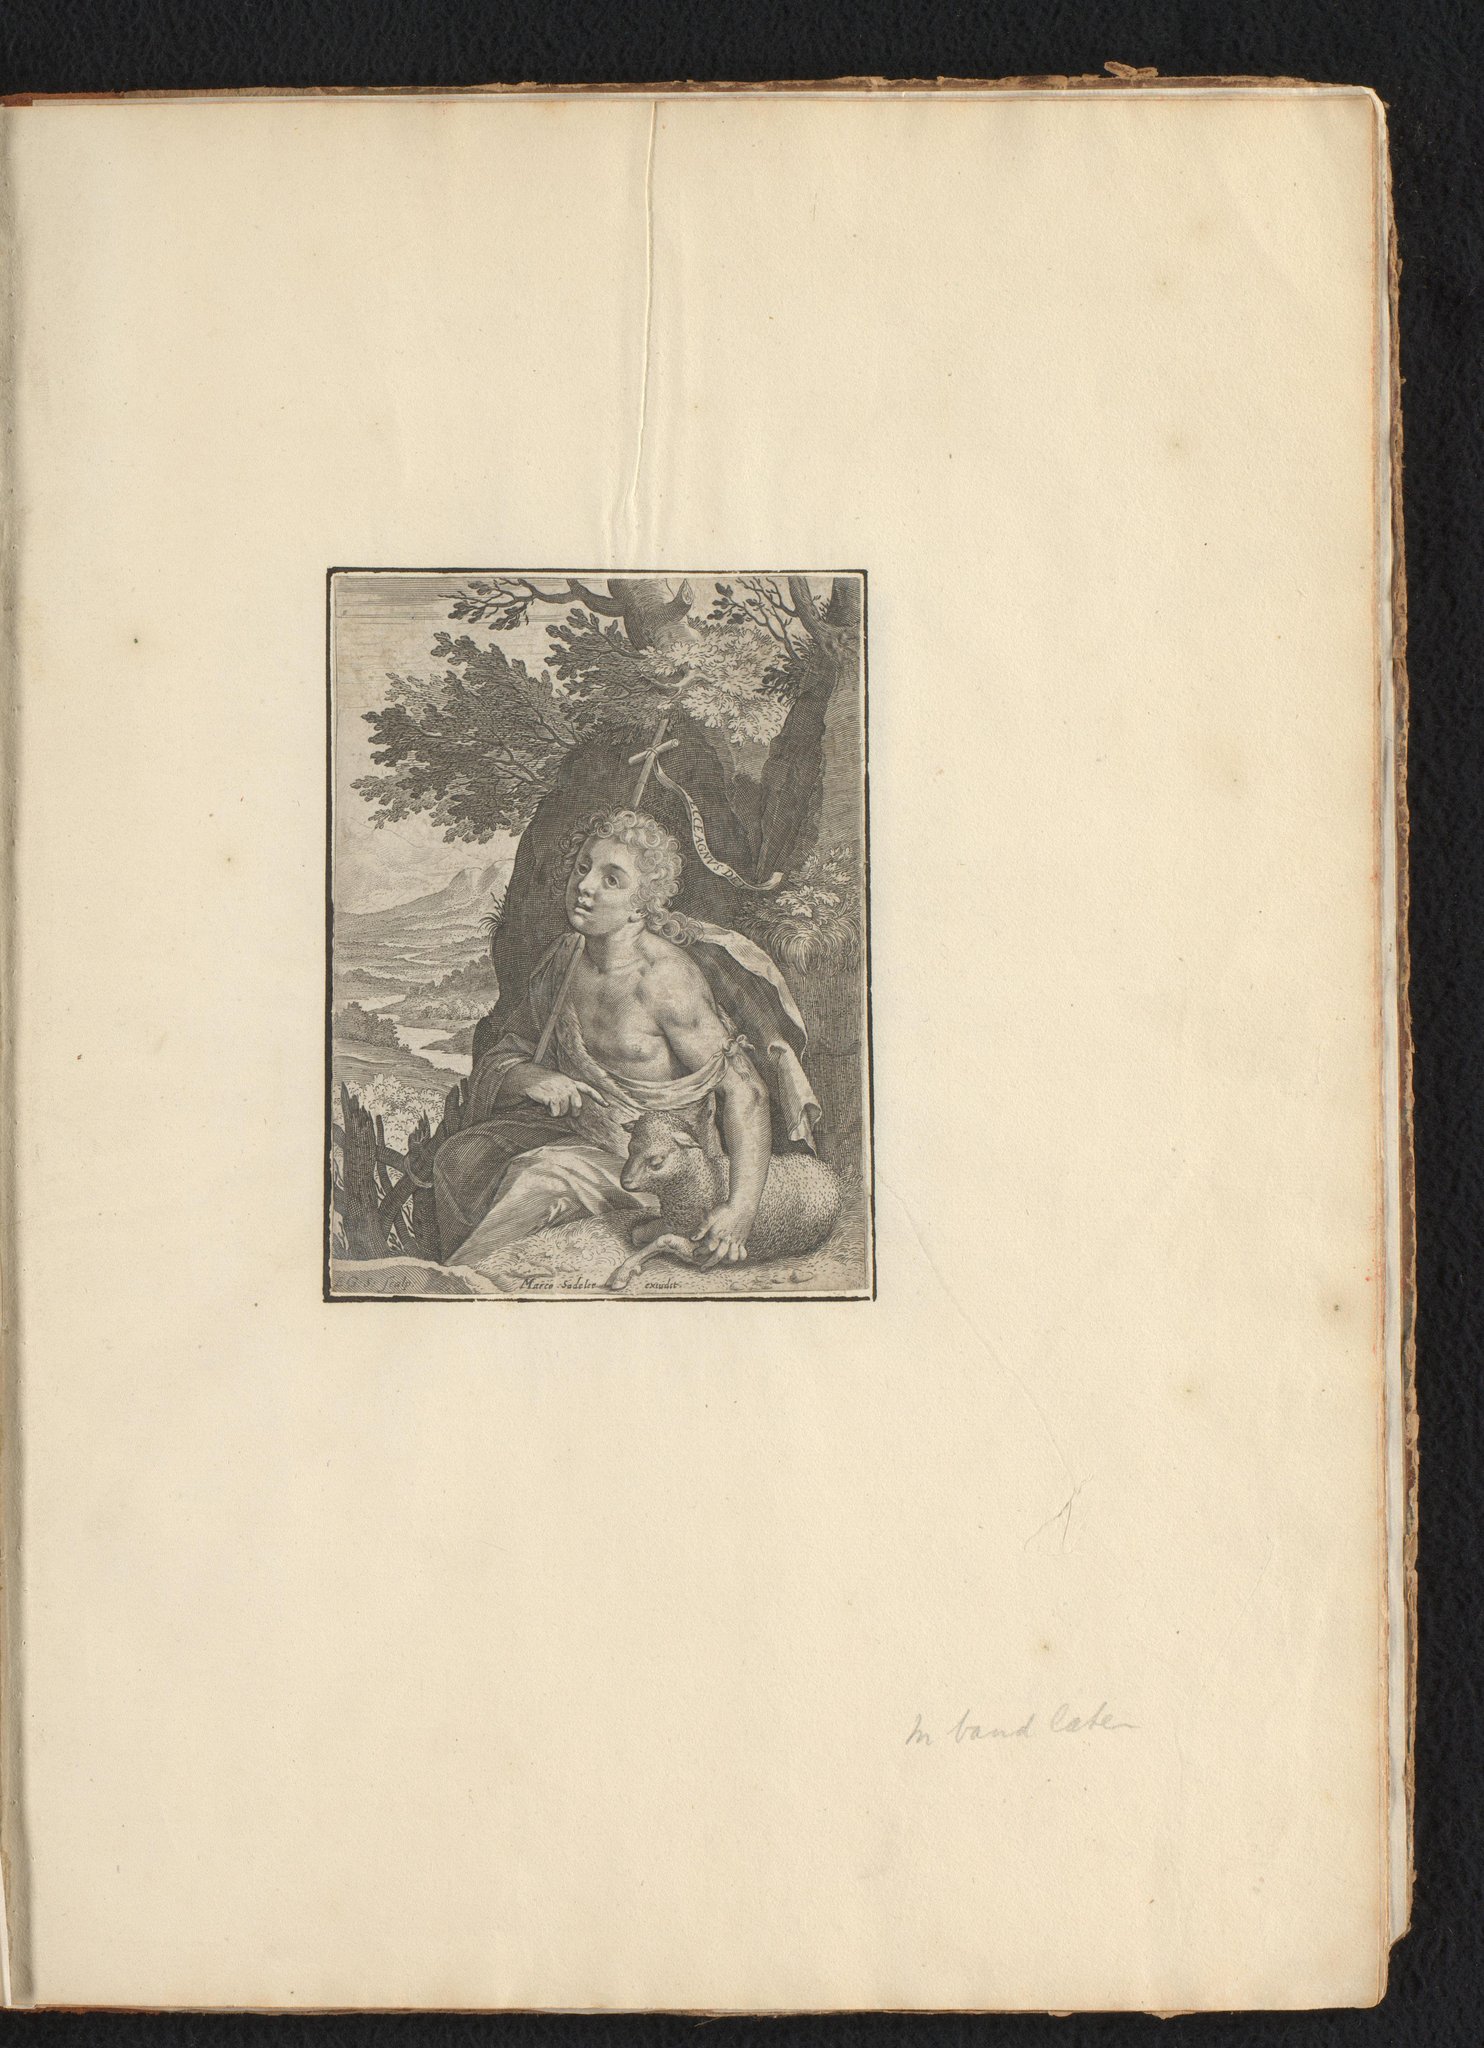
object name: print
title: Johannes de Doper als kind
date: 1624-1650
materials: paper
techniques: engraving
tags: john the baptist; possible attributes: book, reed cross, baptismal cup, honeycomb, lamb, staff - early life of male saint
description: Johannes de Doper als kleine jongen, zittend onder een boom, kruisstaf in de rechterhand, zijn linkerarm geslagen om het lam dat naast hem ligt. Heuvellandschap in verschiet. Met onderschrift in Latijn. Deze prent maakt deel uit van een album.